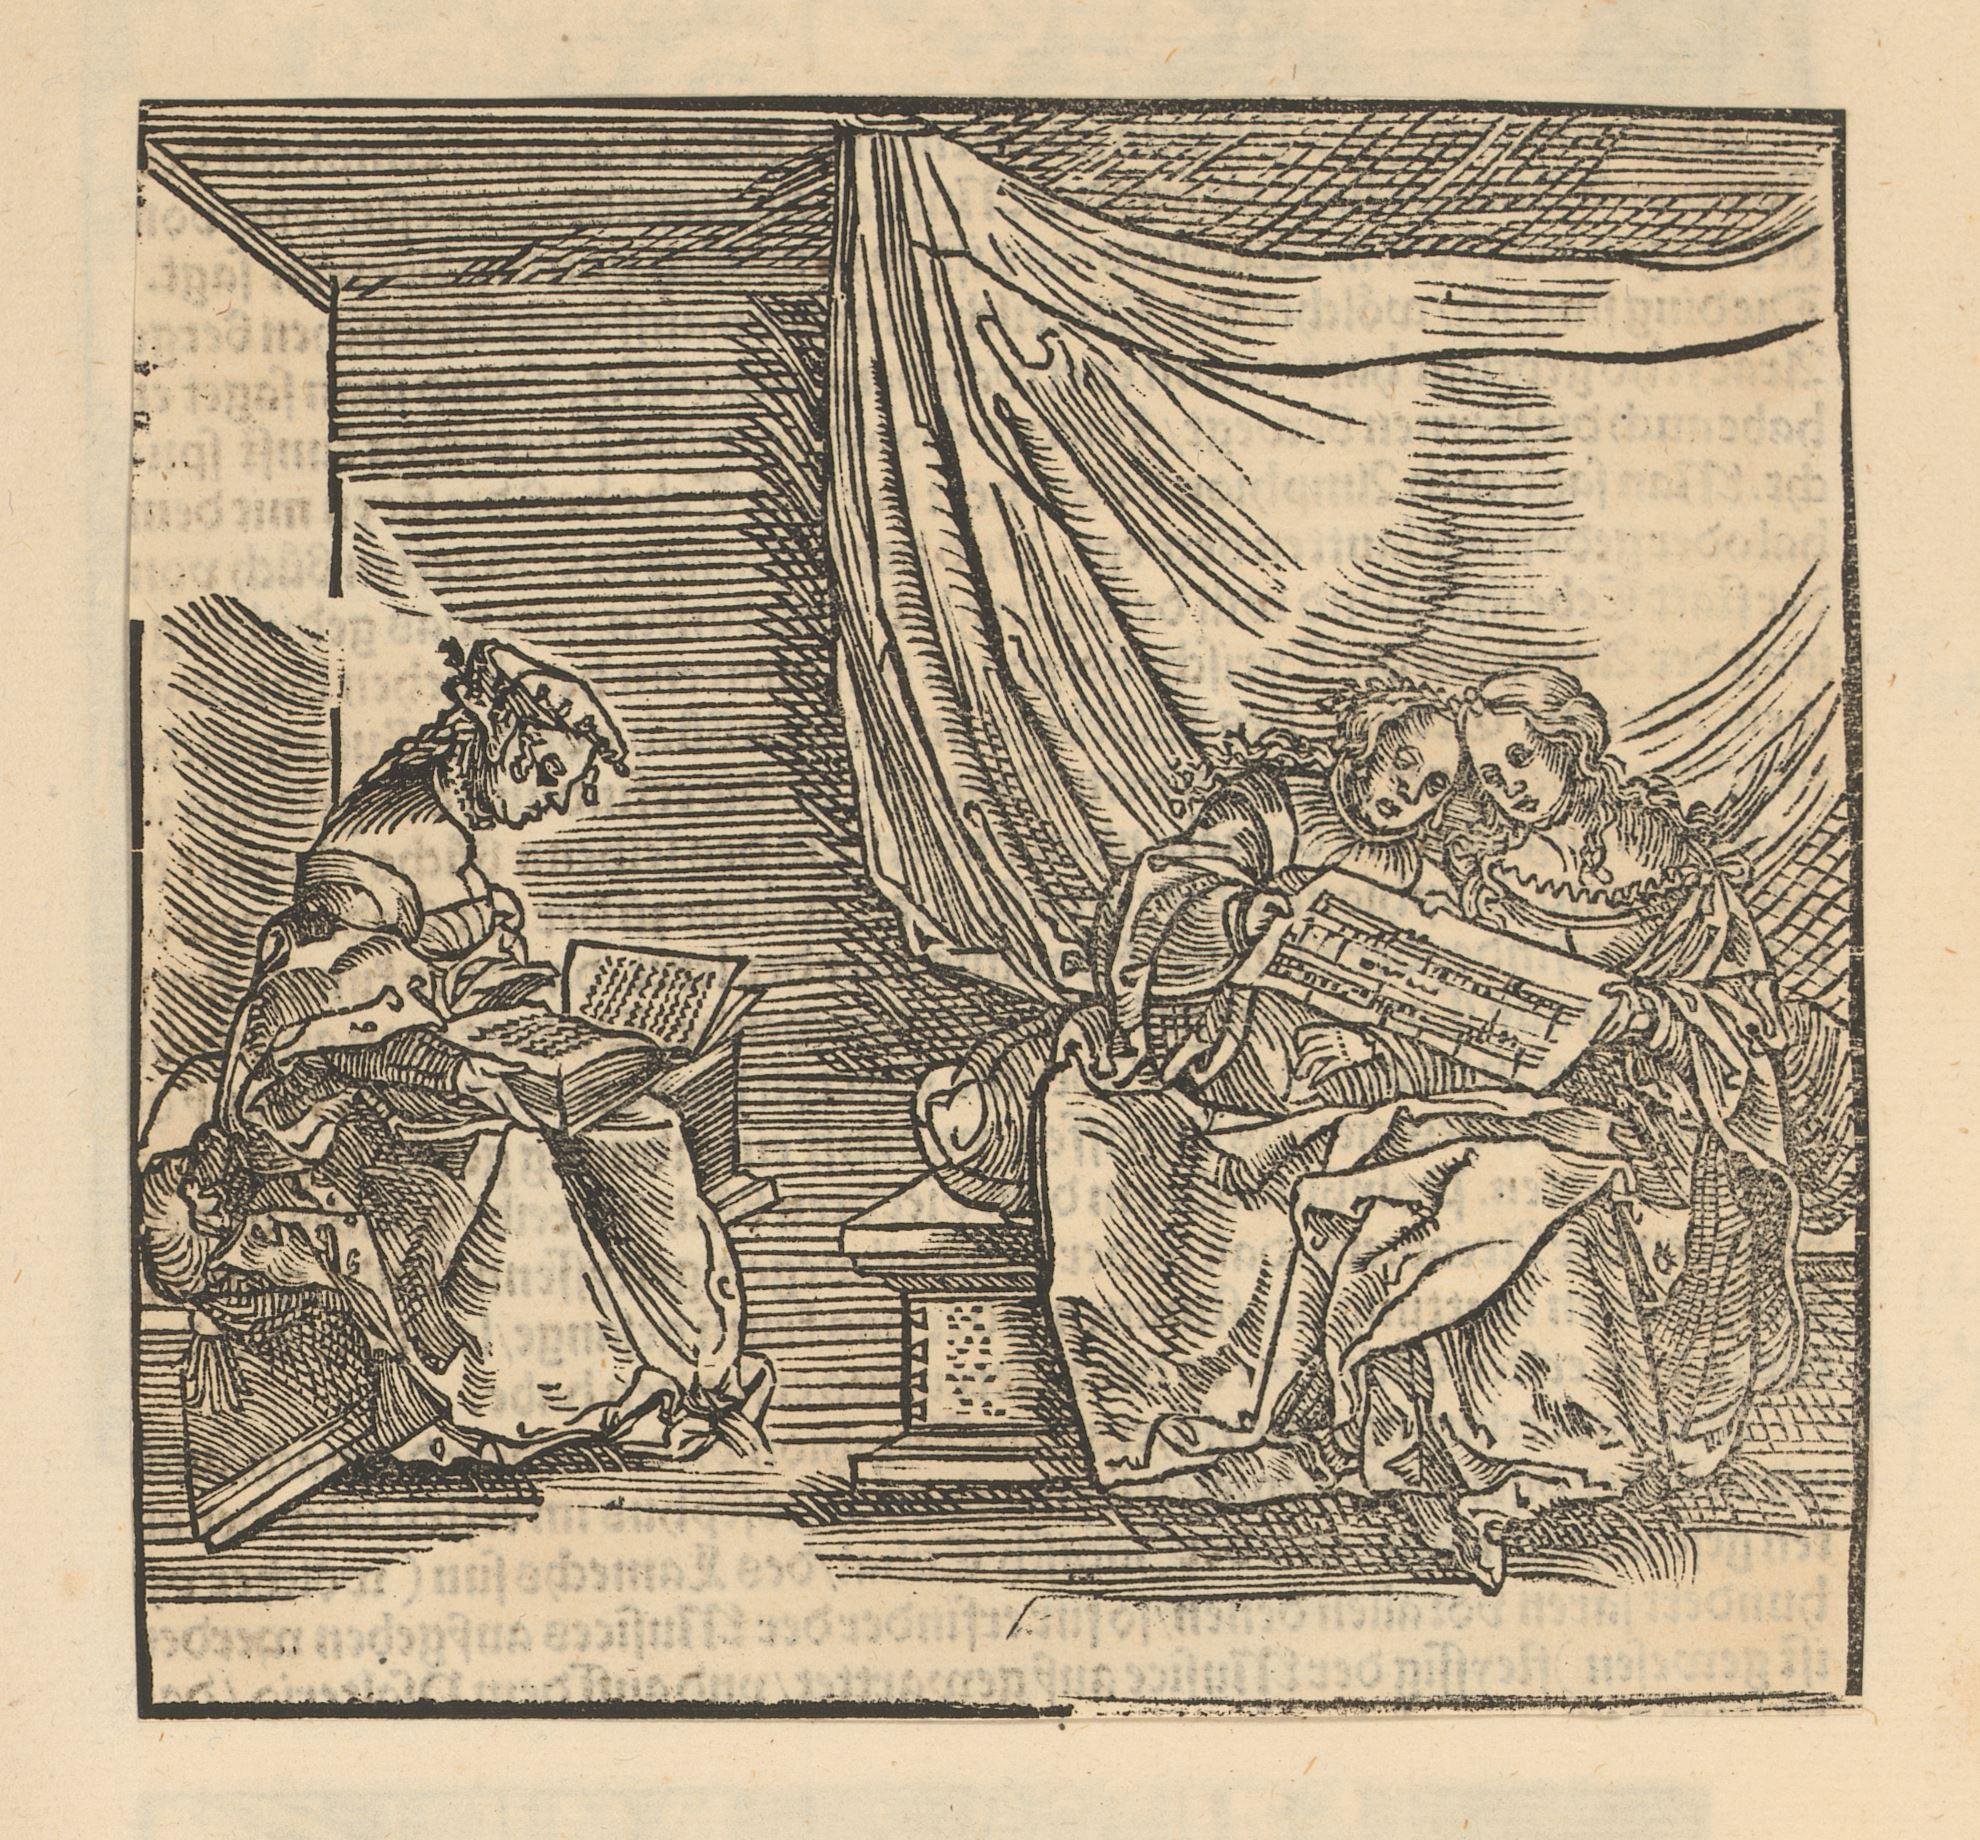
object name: album leaf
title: Drie zingende figuren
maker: Anonymous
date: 1490-1534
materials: paper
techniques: letterpress printing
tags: singing of psalms, hymns, etc.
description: Prent is gebruikt in: Teütsch Cicero. [Vertaald uit het Latijn door] Johannes von Schwarzenberg. Augsburg: Hans Steiner, 1534.